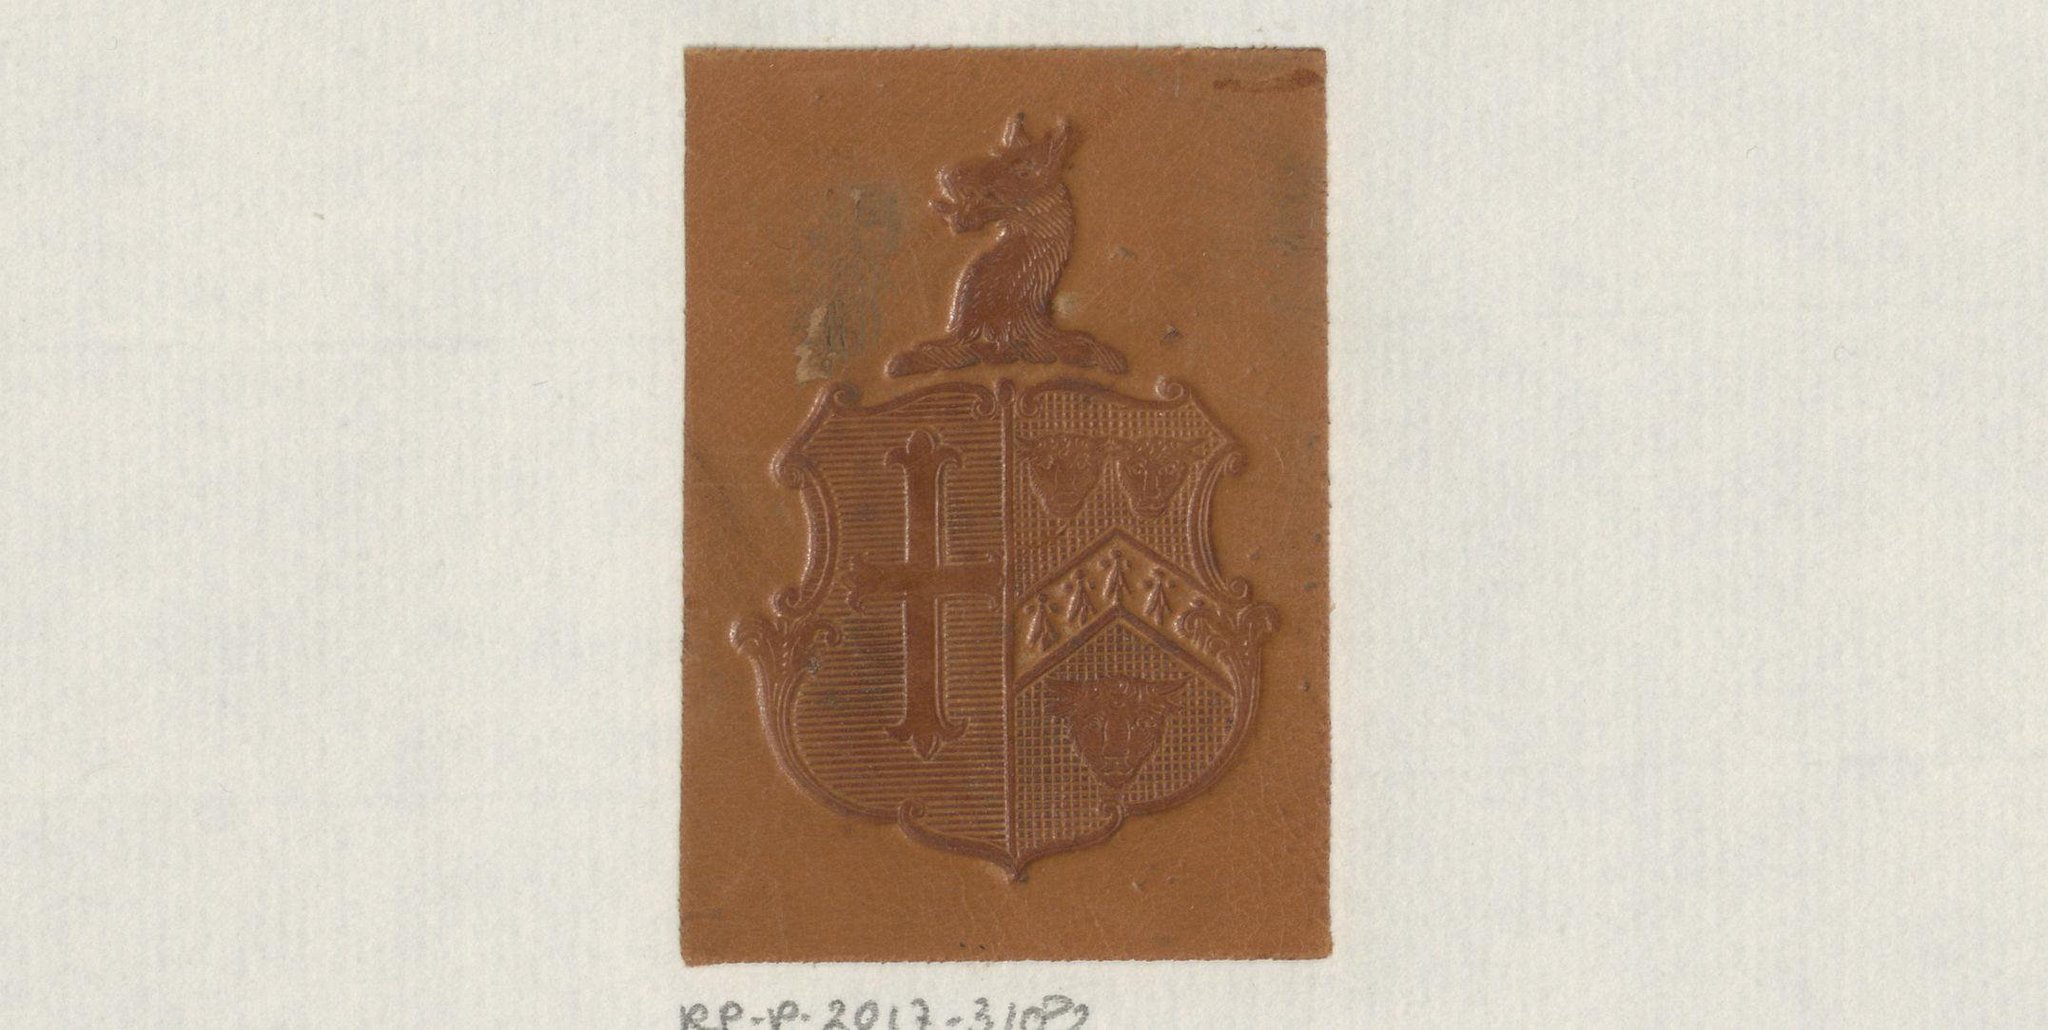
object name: bookplate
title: Ex libris van onbekend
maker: Anonymous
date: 1800-1950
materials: leather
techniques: printing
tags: dragon, armorial bearing, heraldry